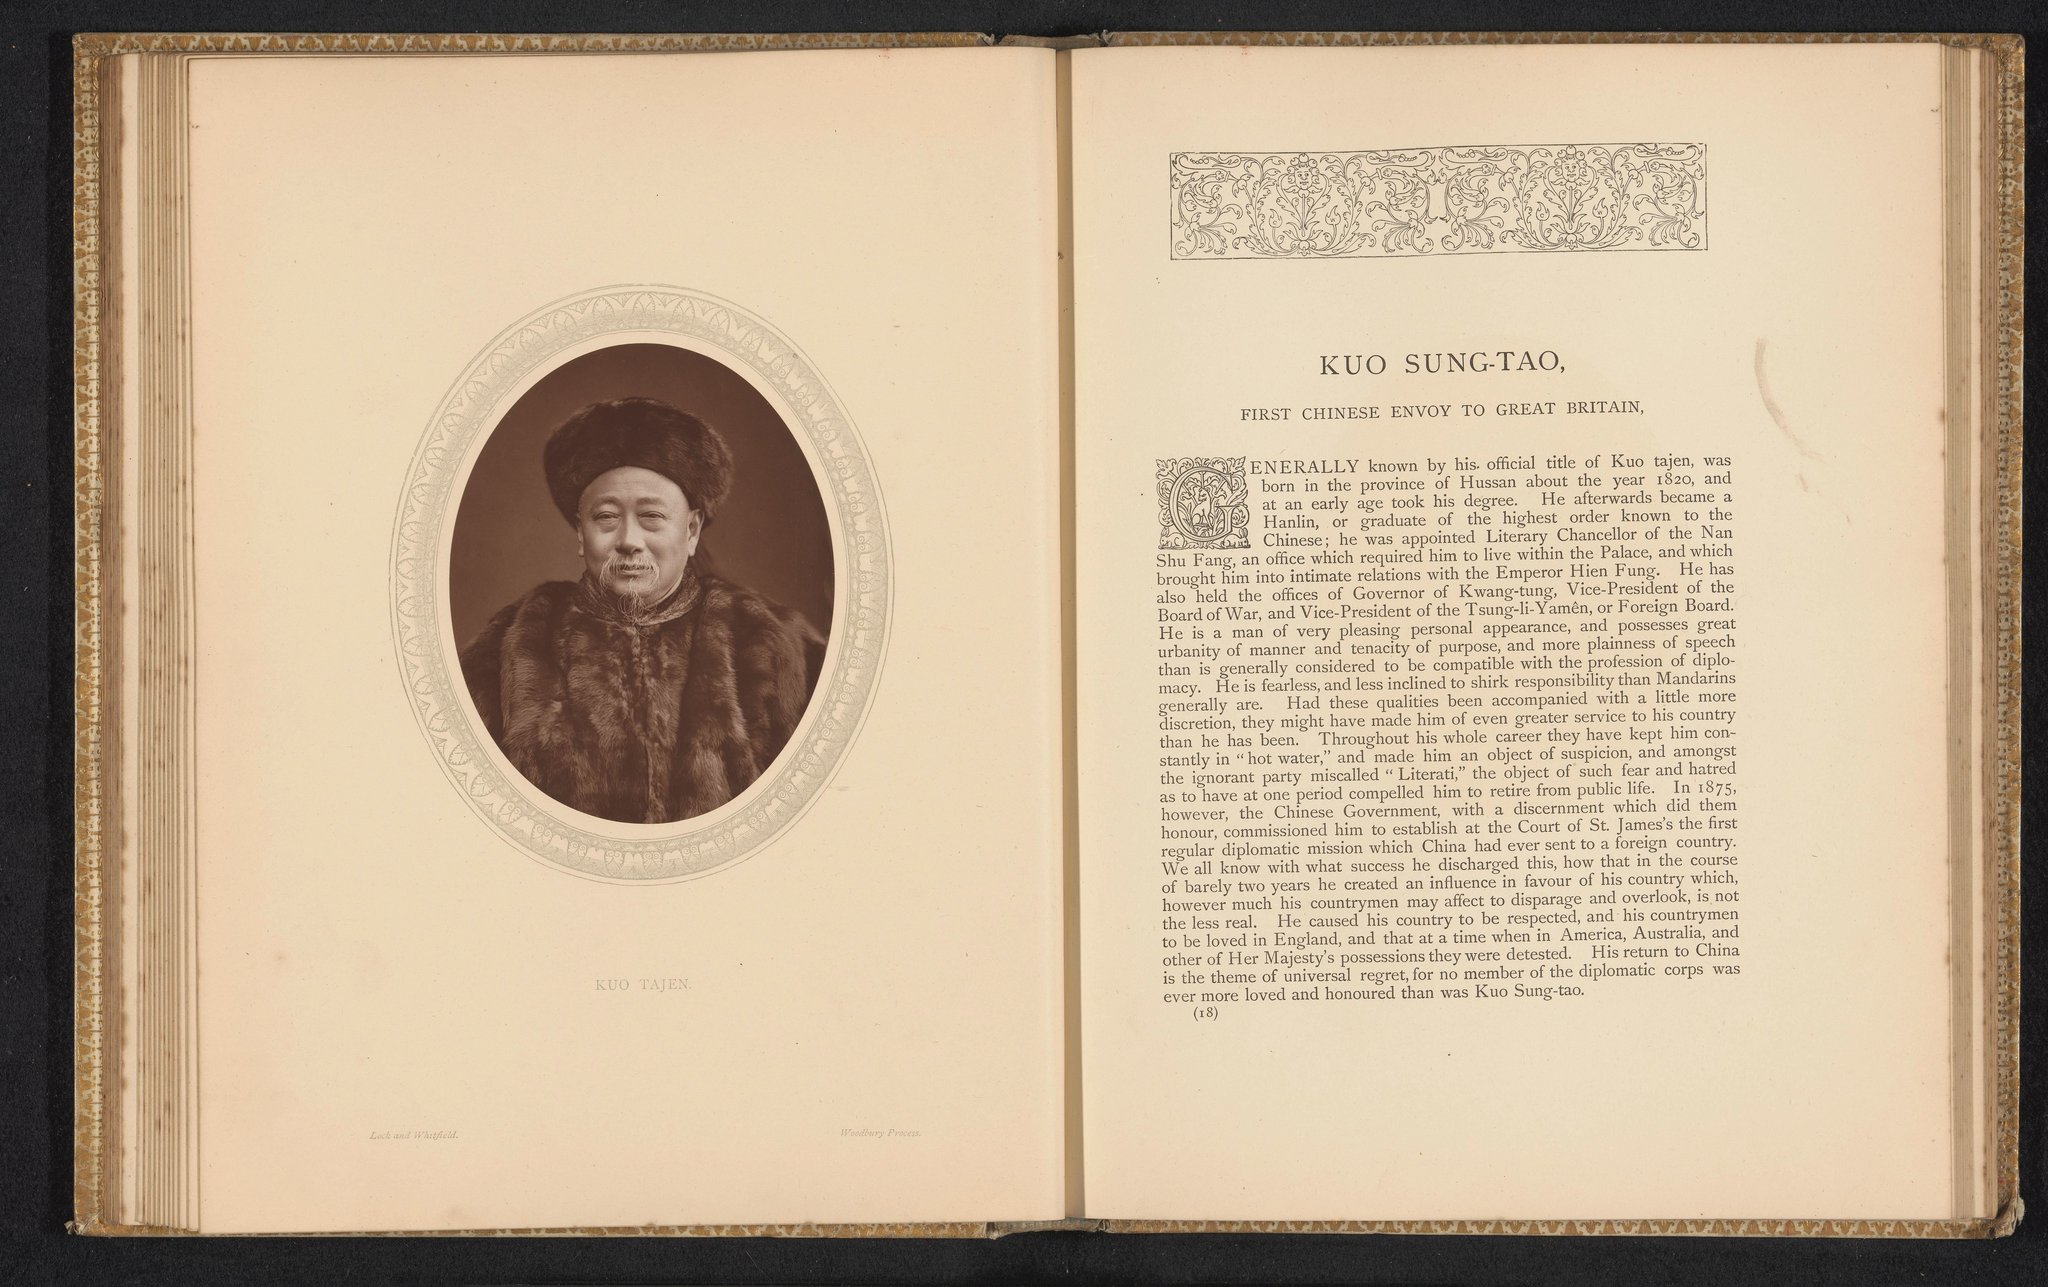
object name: photomechanical print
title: Kuo Tajen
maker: Anonymous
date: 1875-1880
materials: paper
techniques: woodburytype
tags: historical persons (portraits and scenes from the life) (+ (full) bust portrait), diplomacy, diplomat